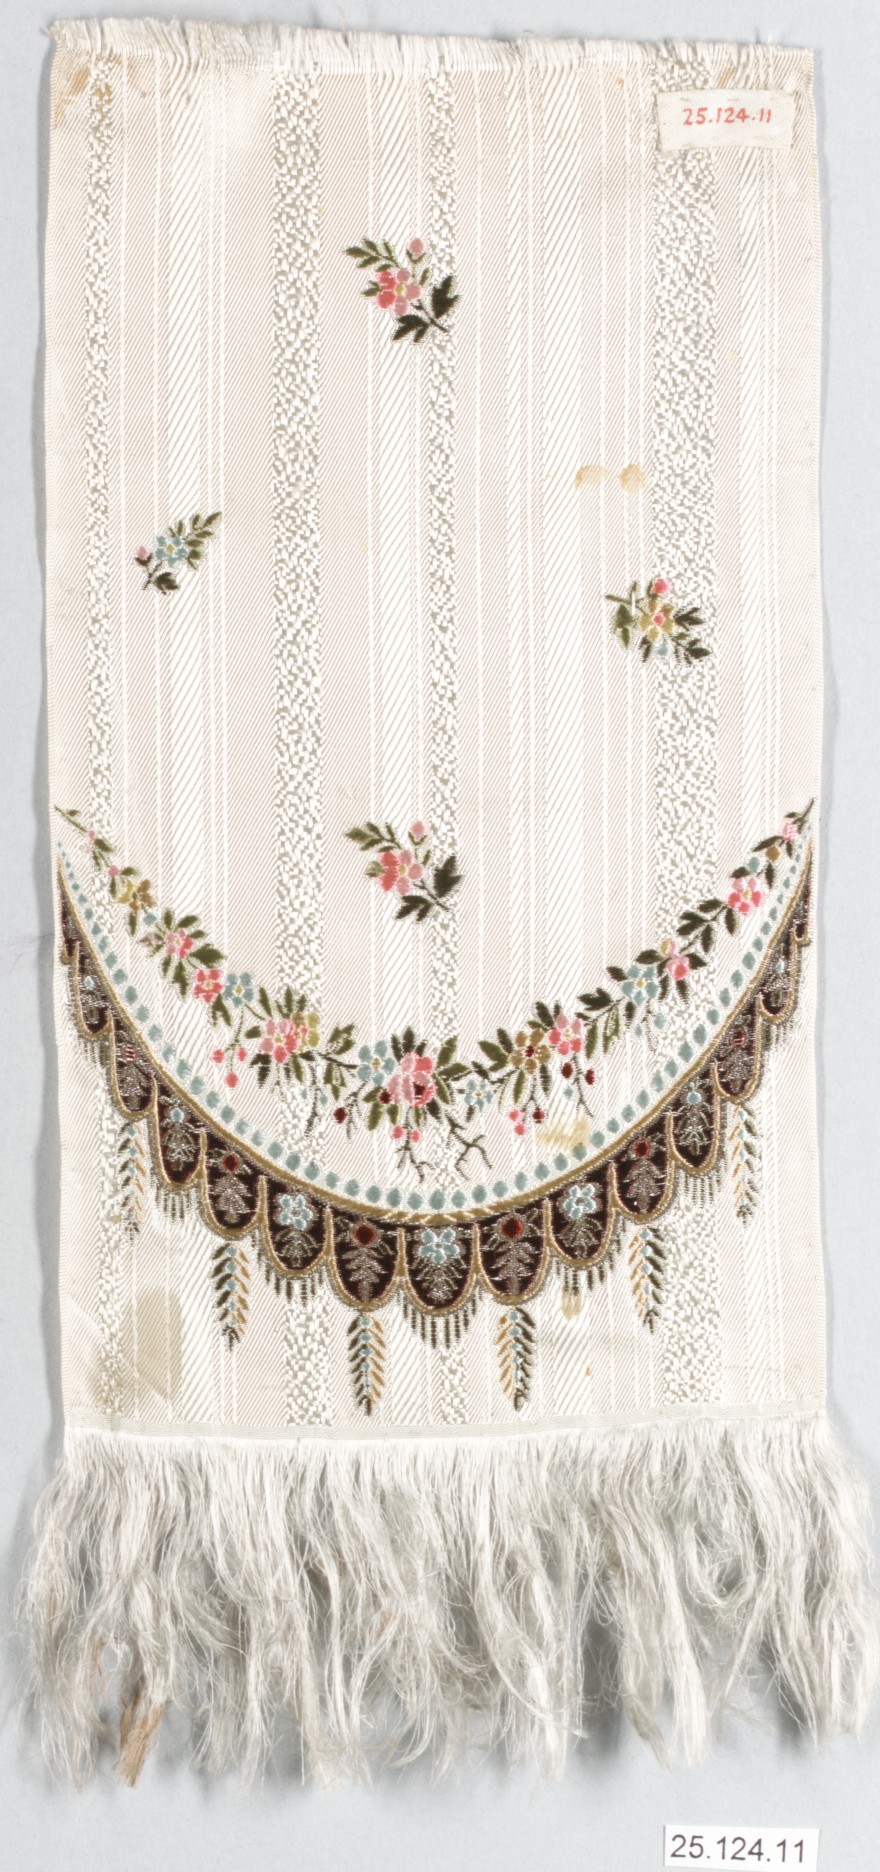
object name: necktie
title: Woman's necktie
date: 1870-1880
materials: metal thread, silk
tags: flowers